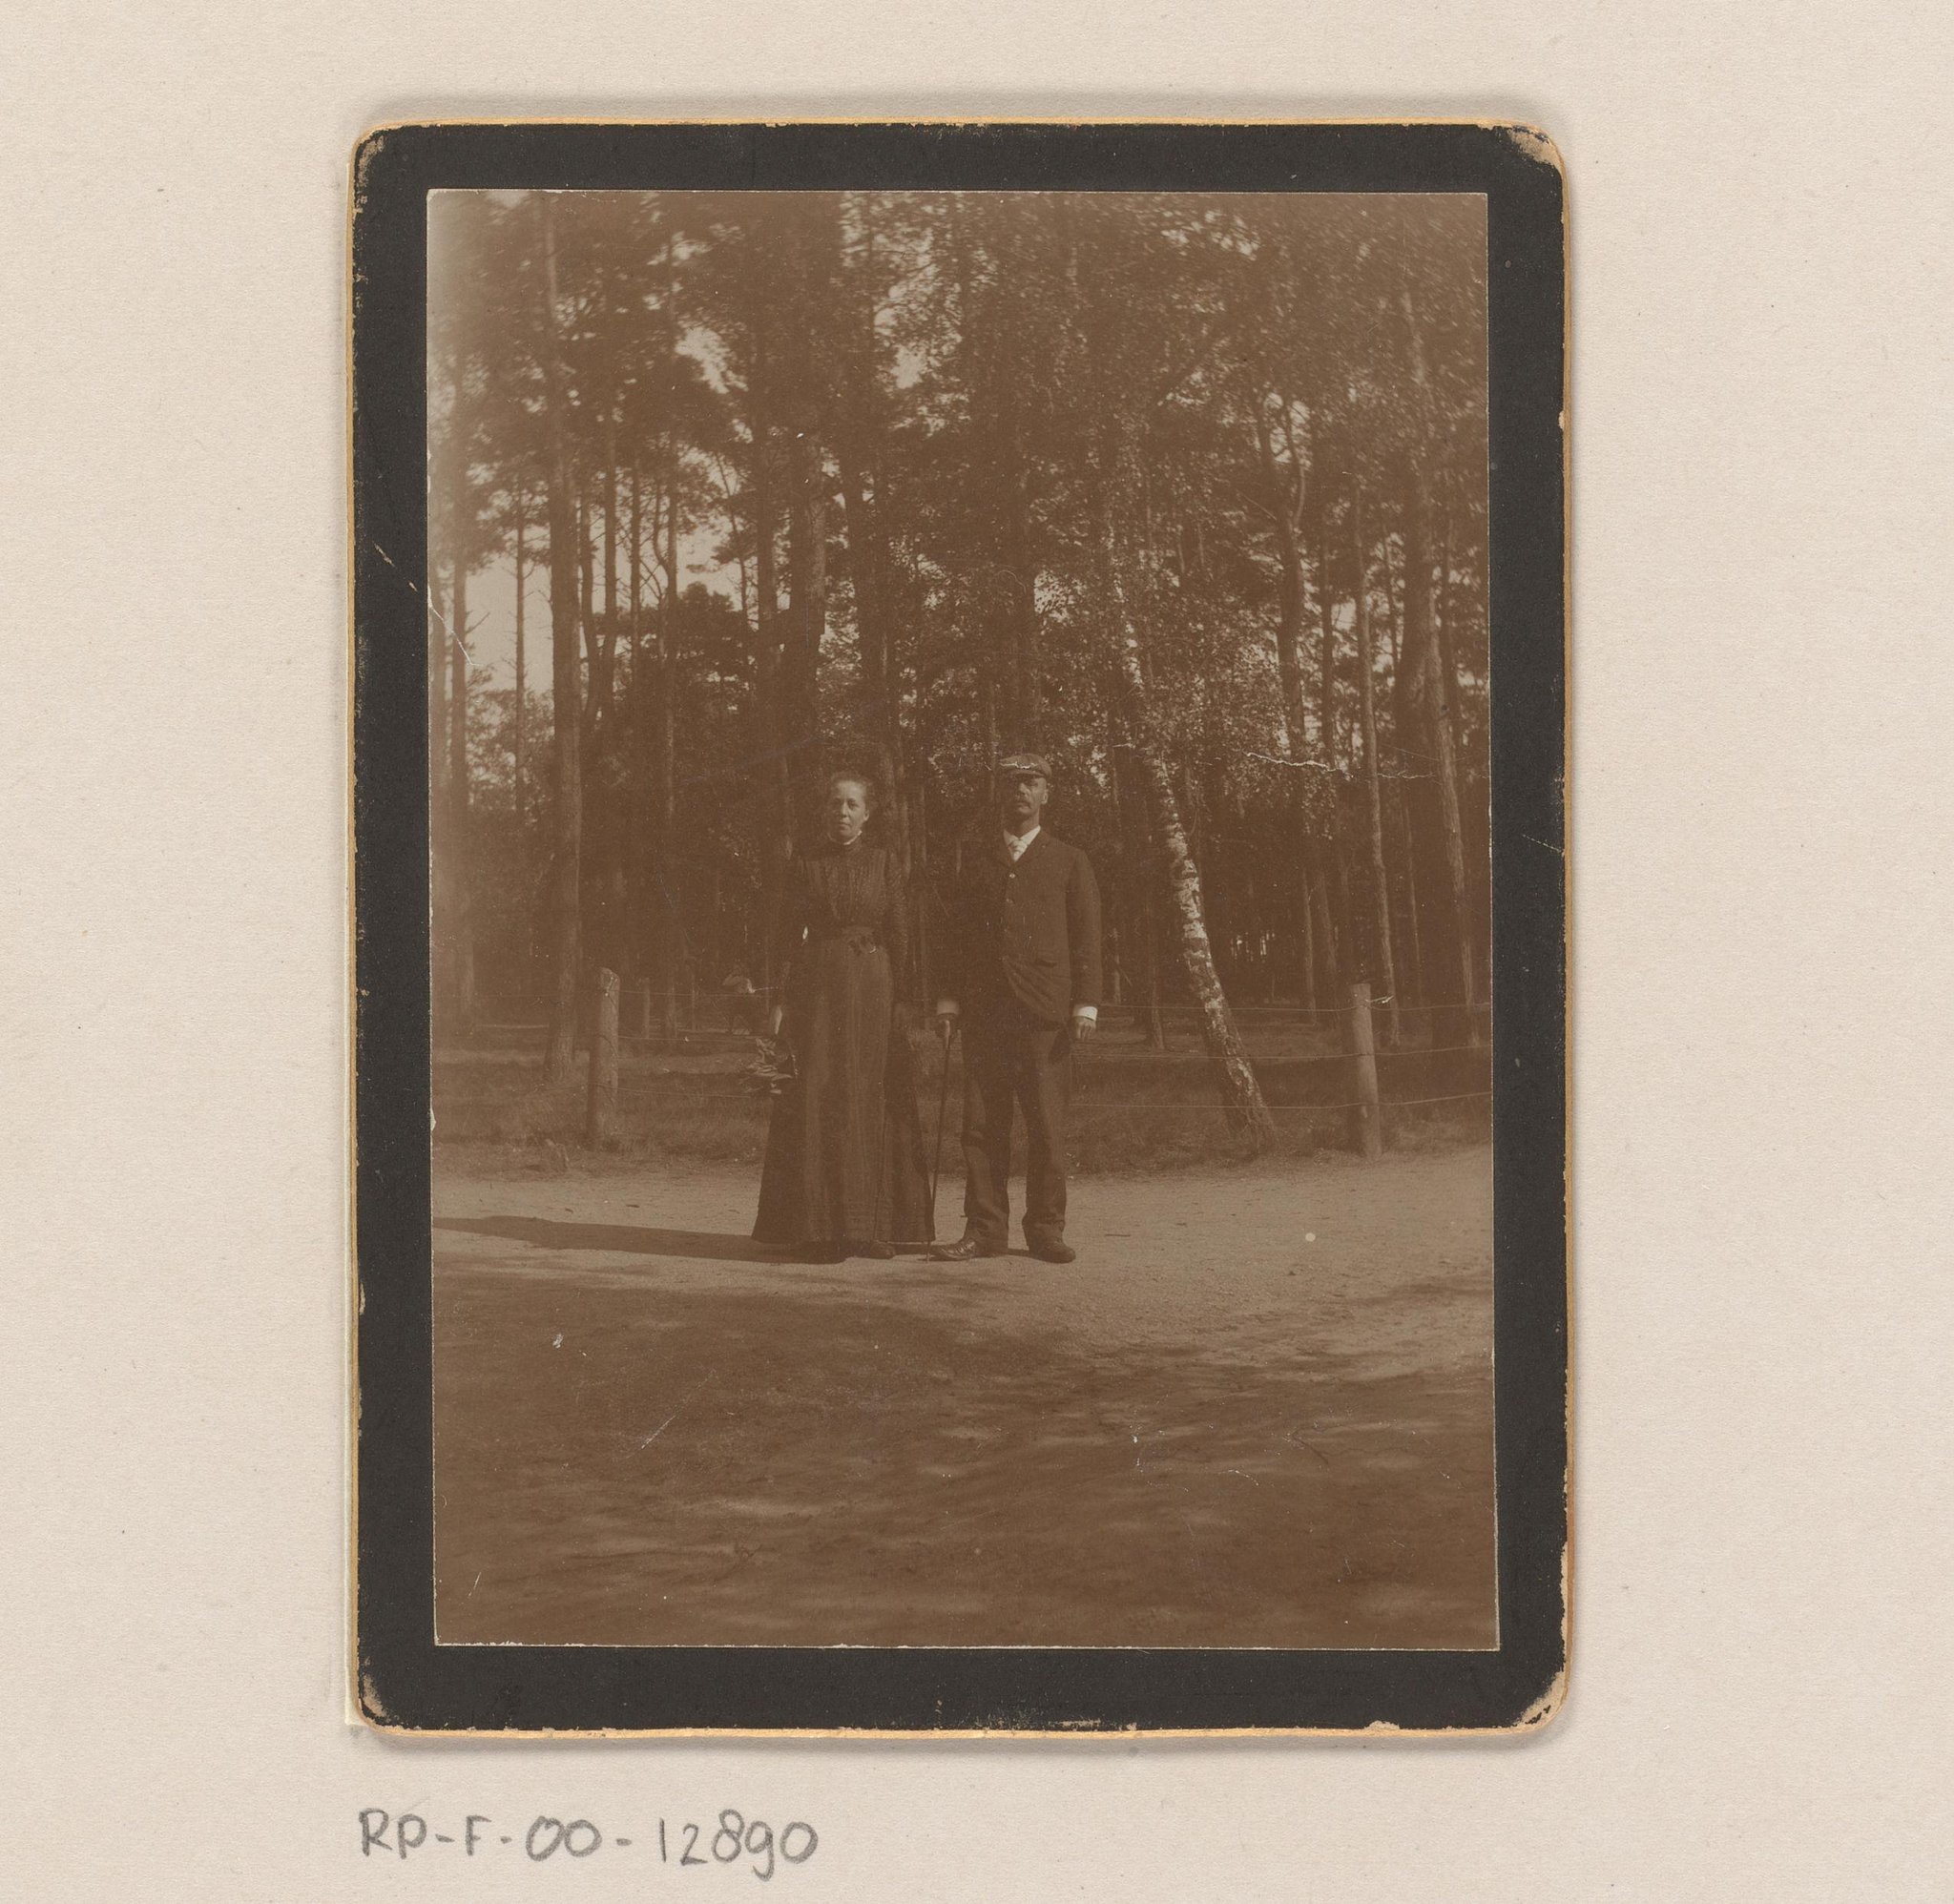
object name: photograph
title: Portret van Herman Gorter en zijn vrouw Louise (Wies) Cnoop Koopmans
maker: Anonymous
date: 1895-1916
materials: paper, cardboard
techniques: collodion silver print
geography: bussum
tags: herman gorter, portrait, self-portrait of artist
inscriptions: inscription: ‘Herman Gorter/ Bussum’